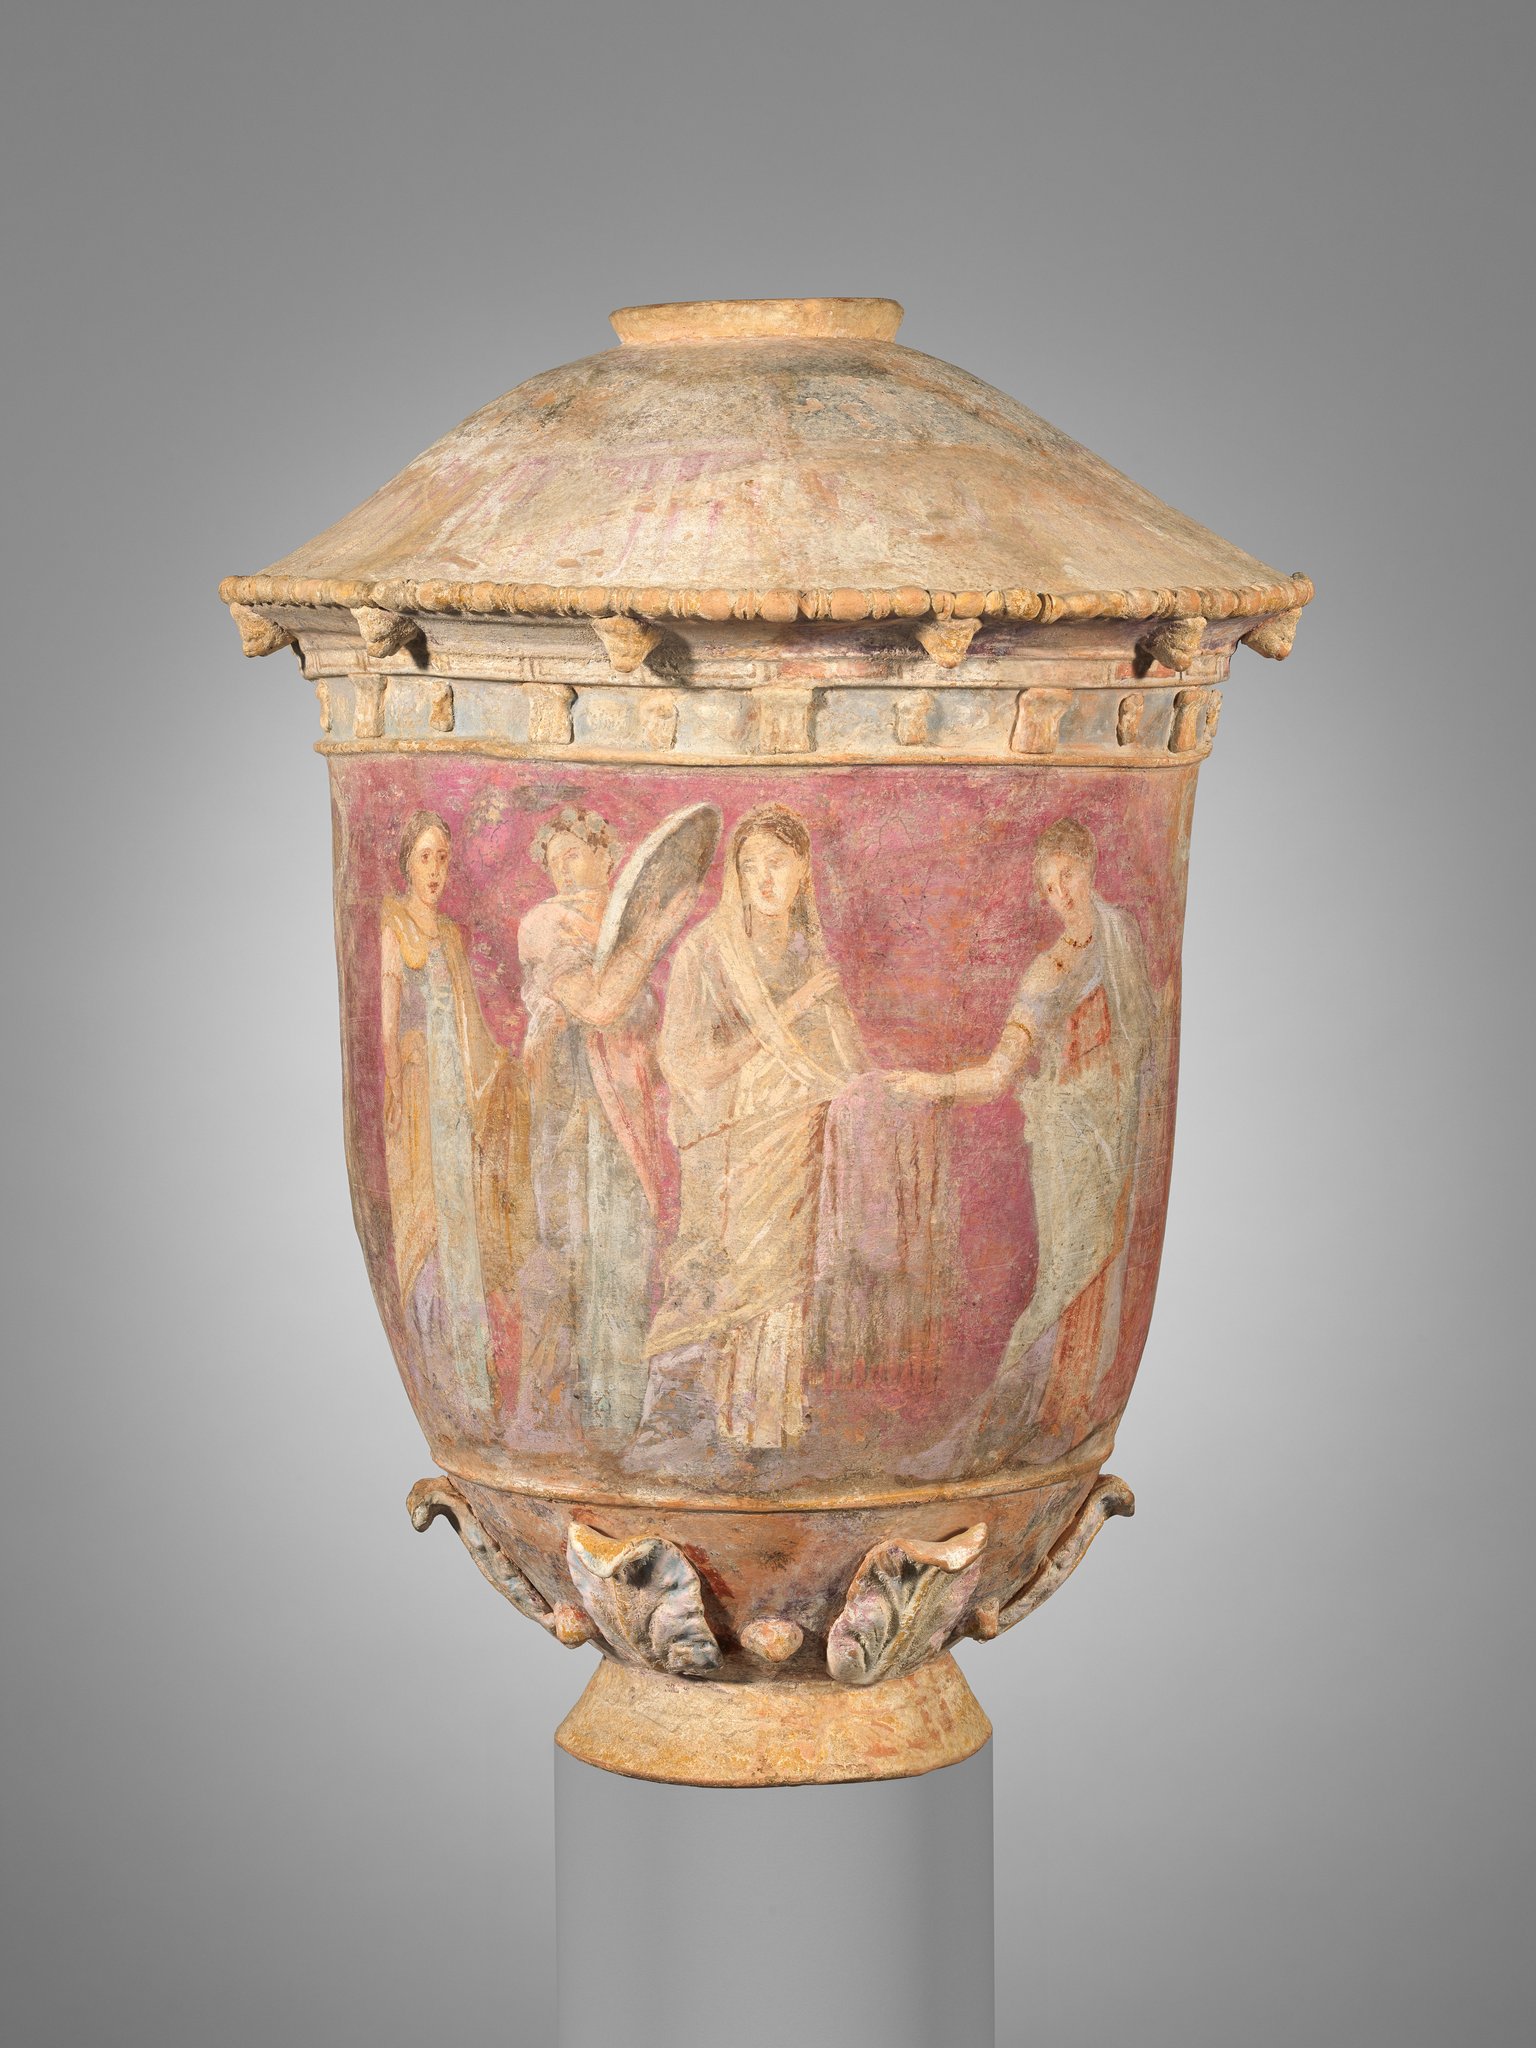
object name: vase, funerary, wedding scene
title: Terracotta vase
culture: greek, sicilian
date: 300-101 BCE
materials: terracotta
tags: women,weddings